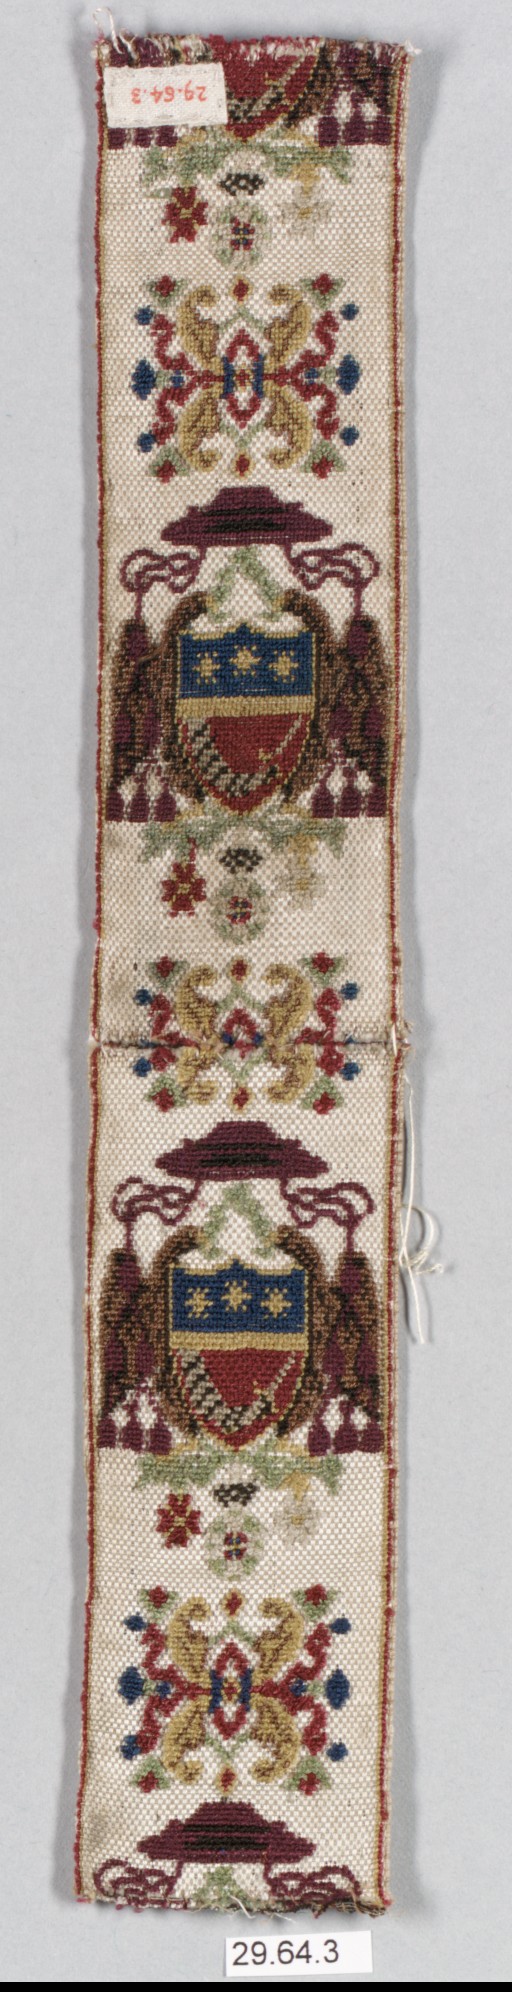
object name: galloon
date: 1701-1900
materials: silk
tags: coat of arms